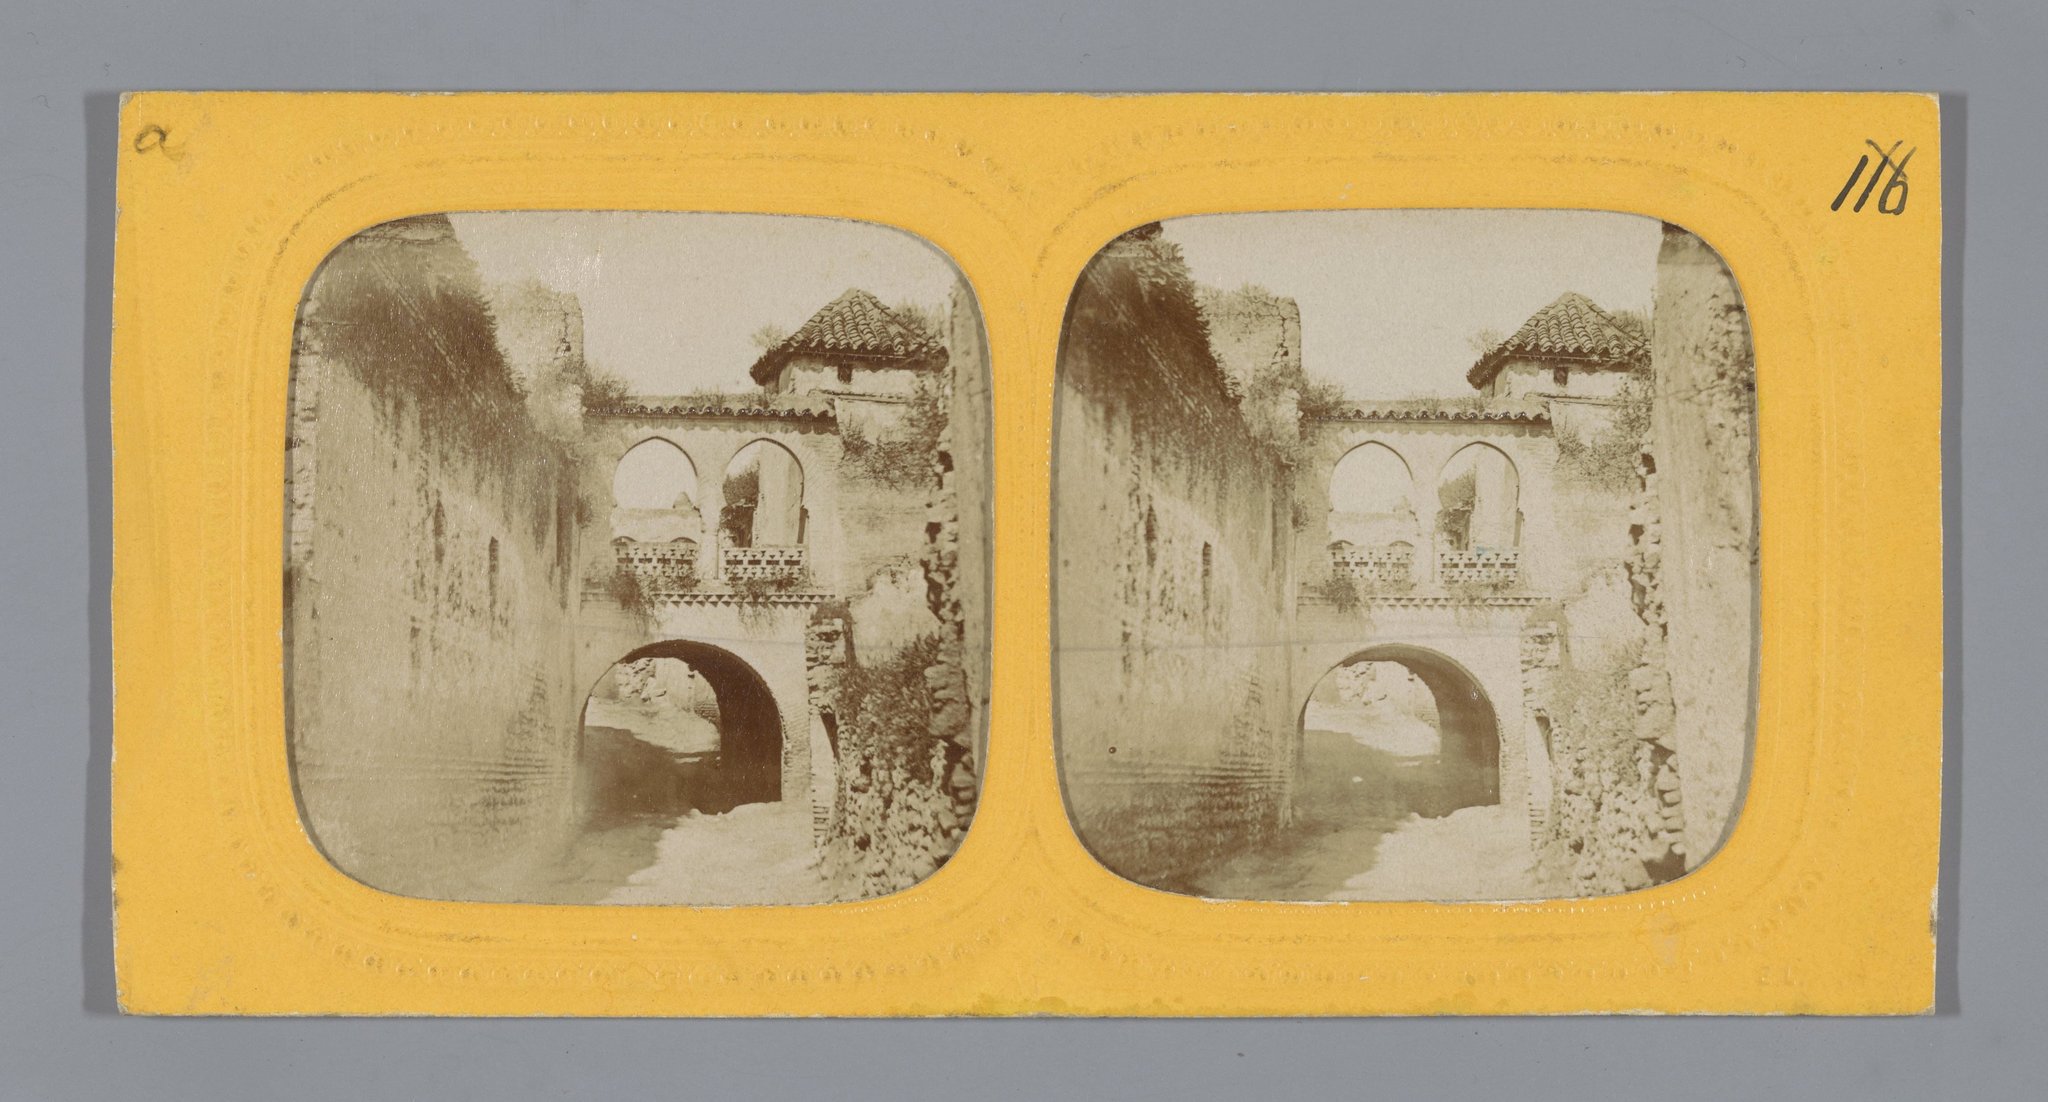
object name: tissue stereograph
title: Poort in Tunis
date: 1855-1875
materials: cardboard, paper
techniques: albumen print, hand coloring, perforating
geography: tunis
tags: gate ~ fortified city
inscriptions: inscription: ‘a’, number: ‘116’